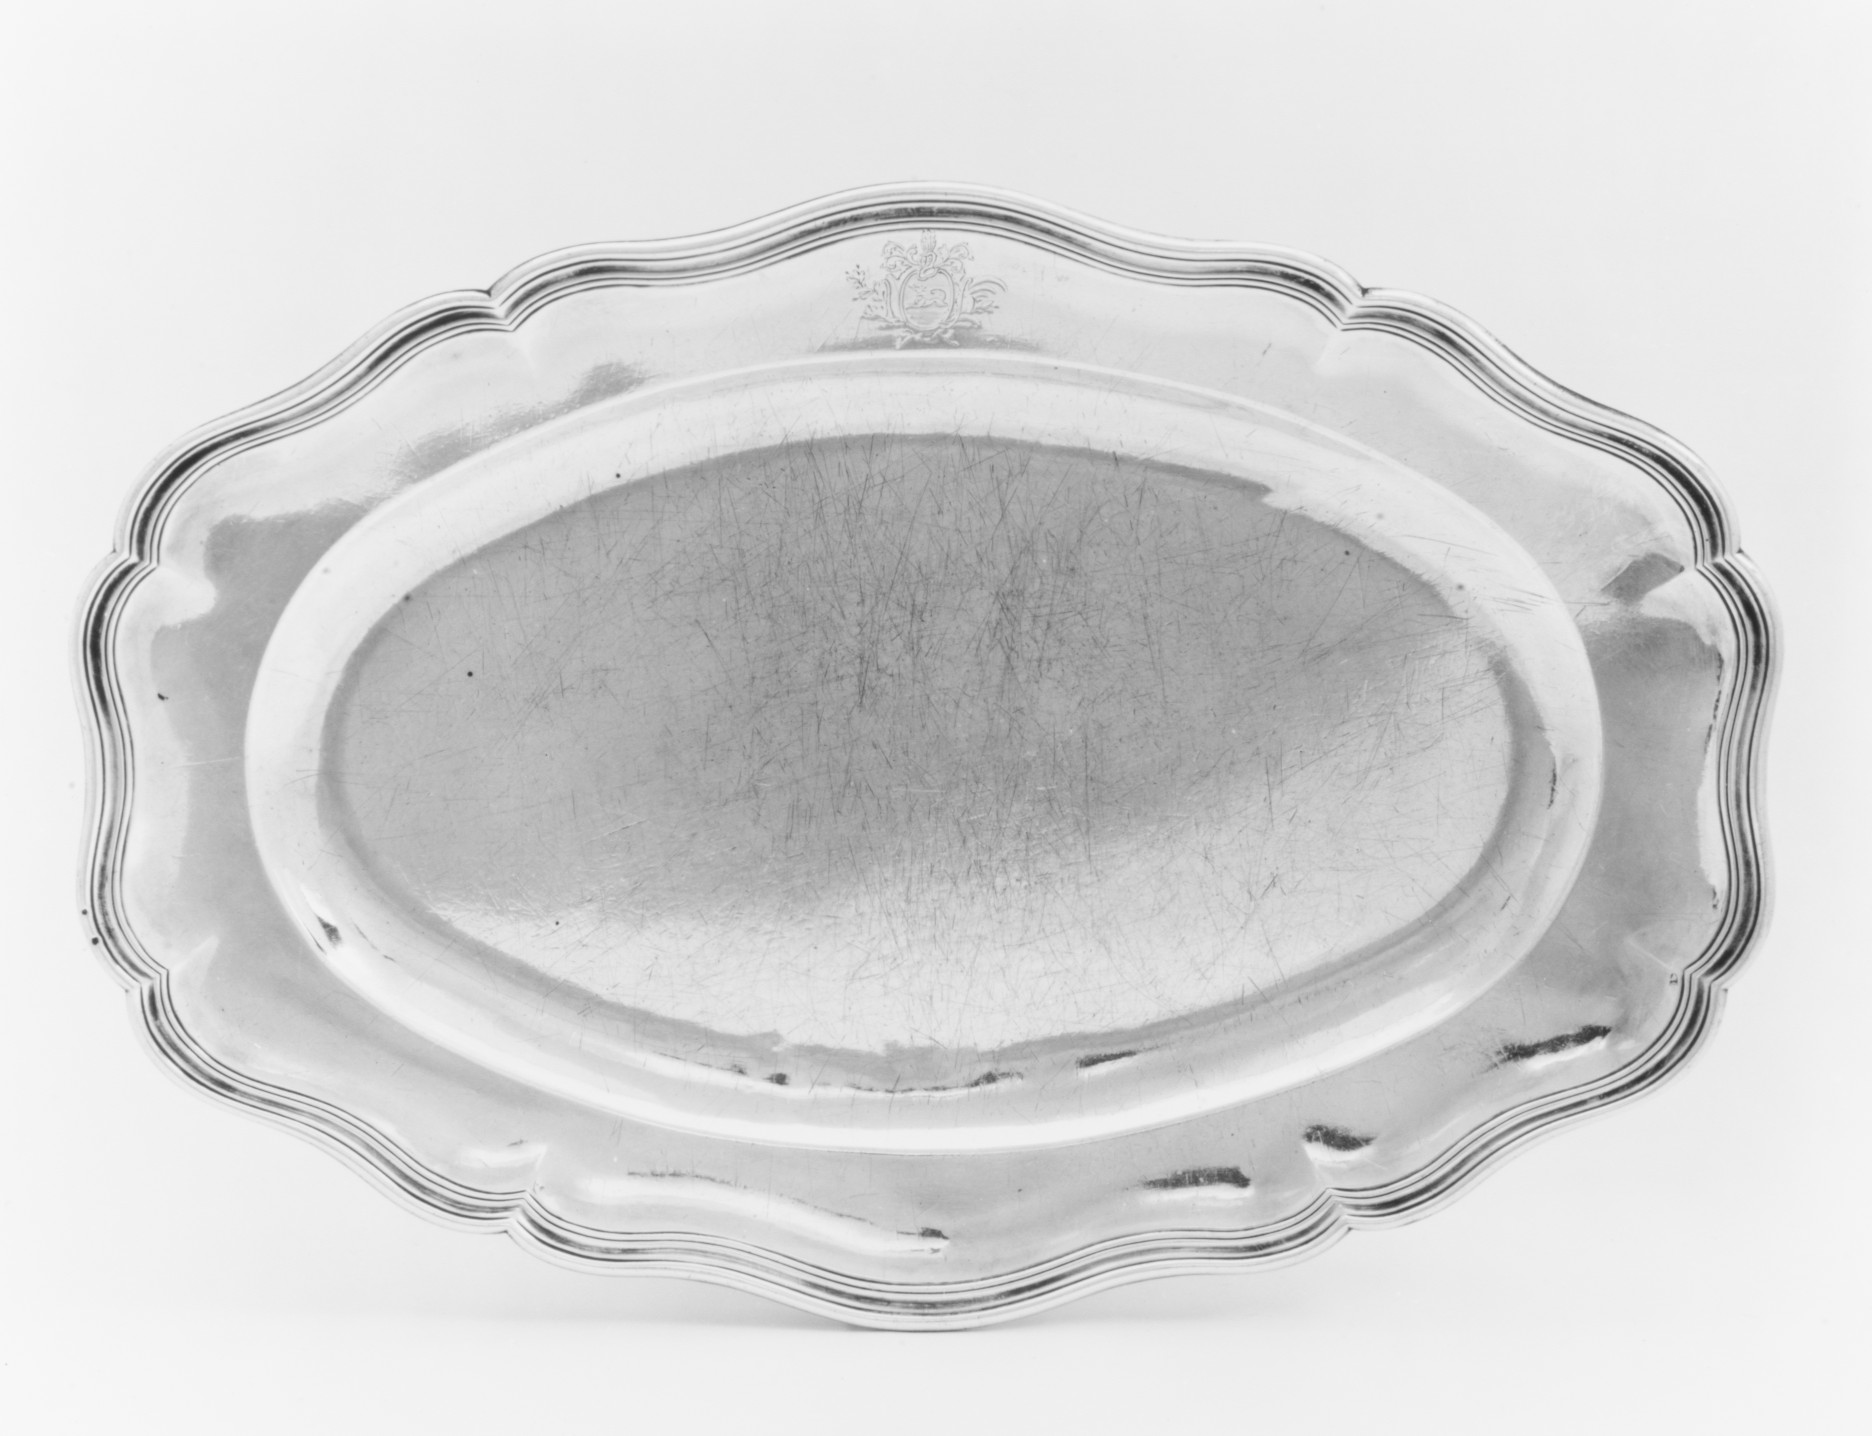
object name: platter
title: Platter (part of a set)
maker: edme-pierre balzac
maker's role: maker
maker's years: 1705-1786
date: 1771-1772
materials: silver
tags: coat of arms